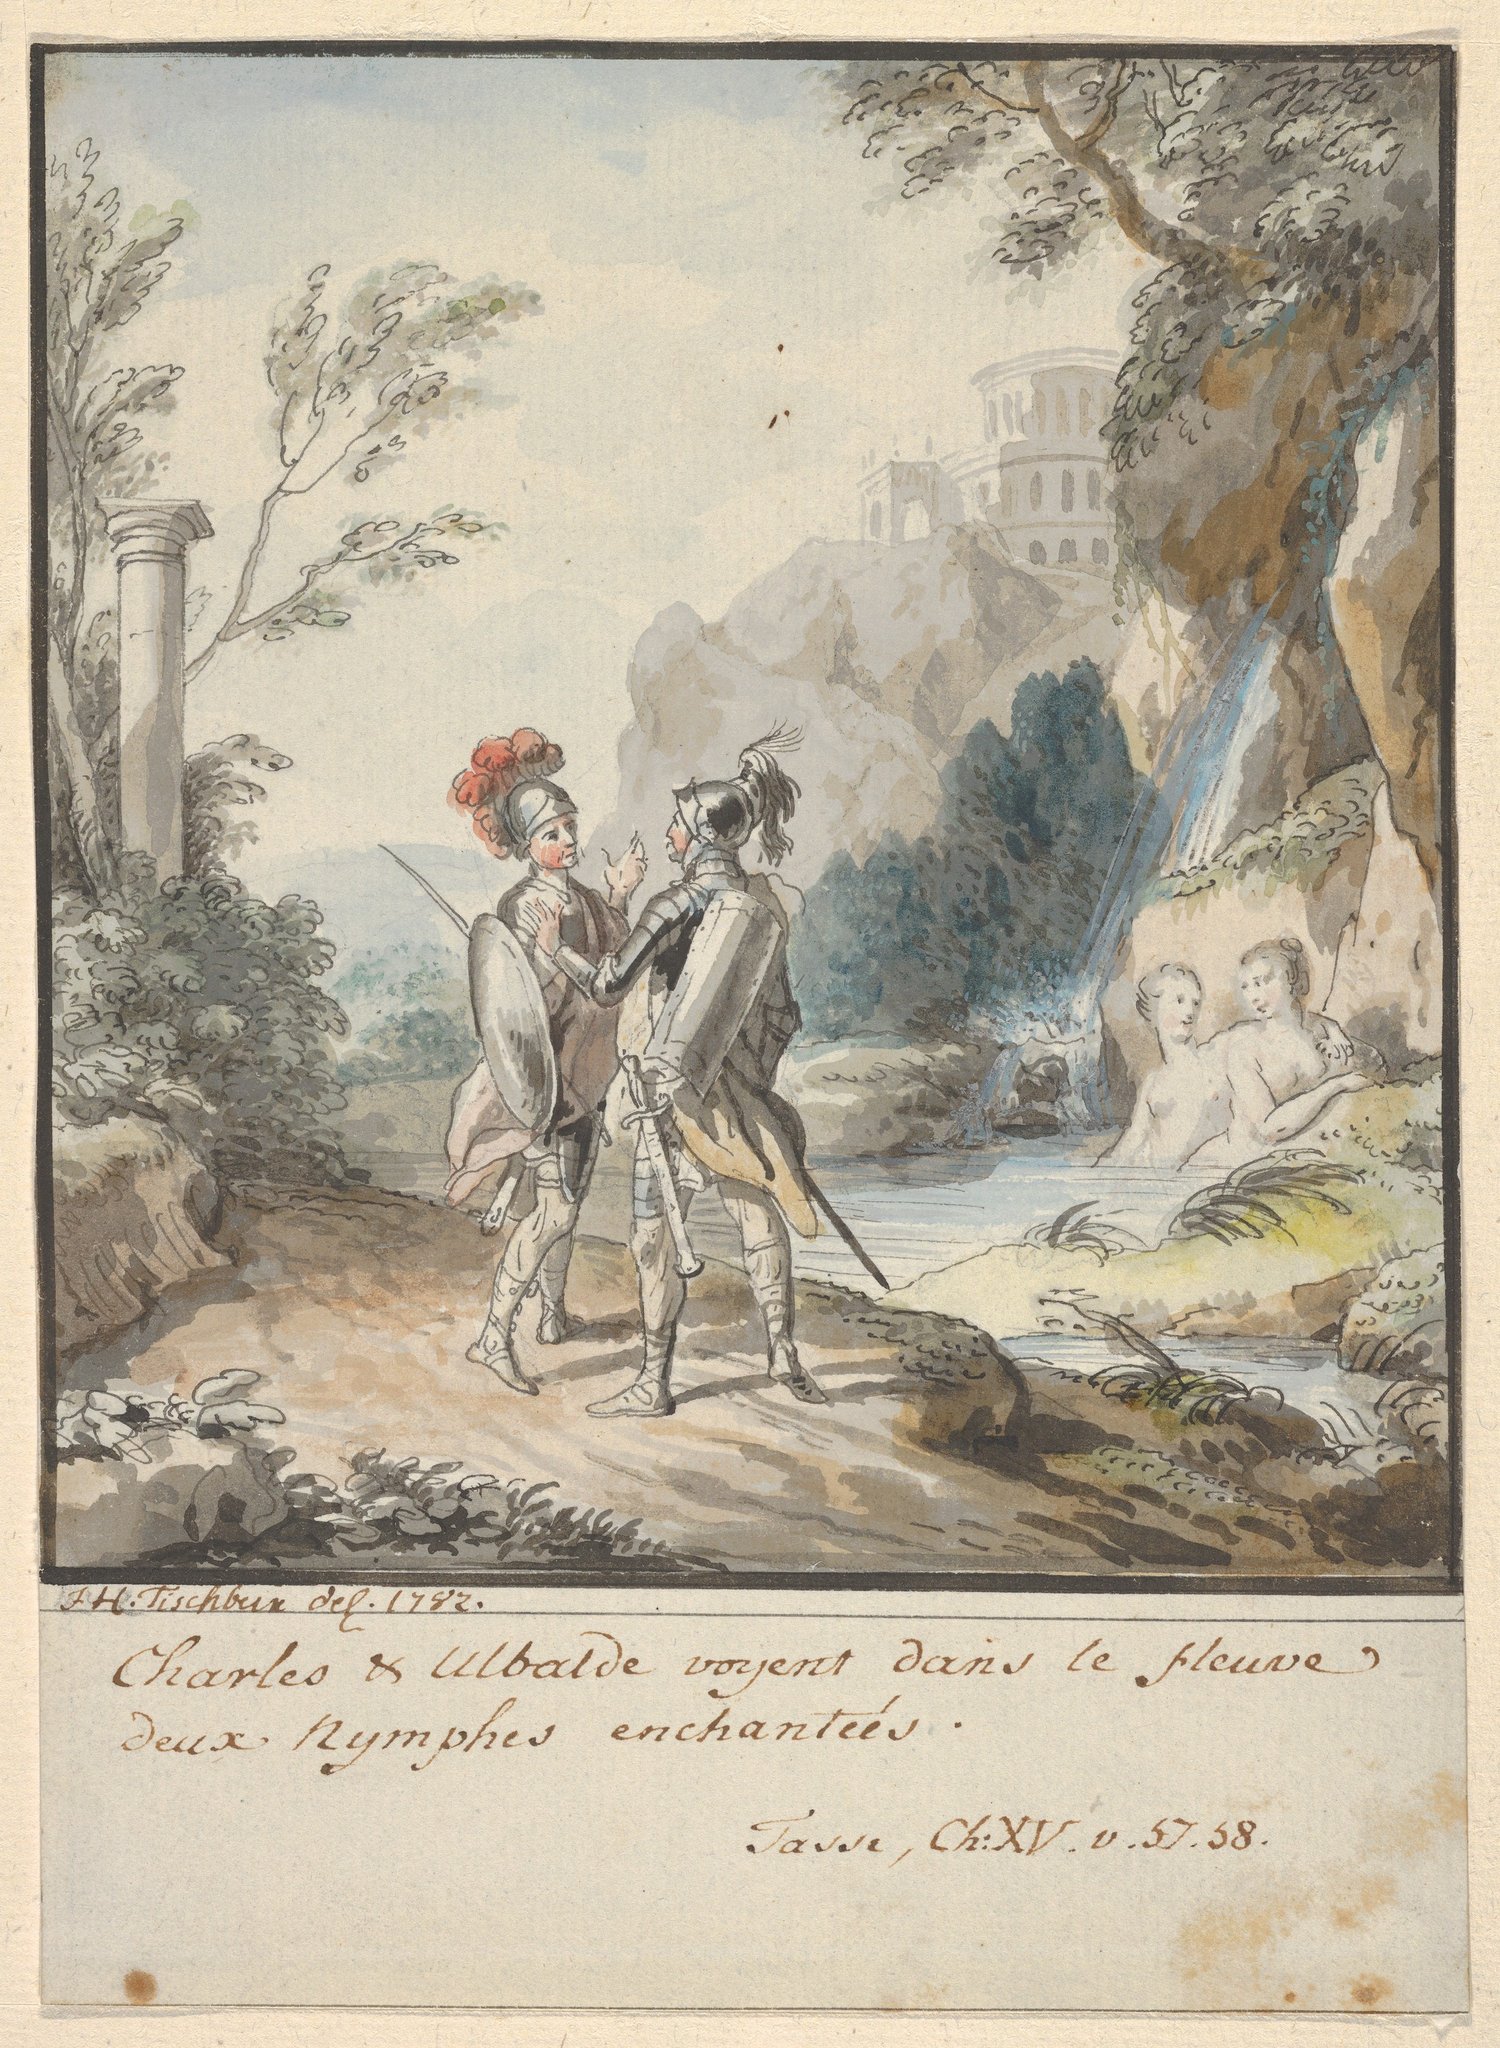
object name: drawing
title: Carlo and Ubaldo Resisting the Enchantments of Armida's Nymphs (from Torquato Tasso's "Gerusalemme liberata", 15:57-58)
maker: johann heinrich tischbein the elder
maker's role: artist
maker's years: 1722-1789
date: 1782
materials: gouache, graphite, ink, watercolor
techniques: pen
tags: buildings,soldiers,men,nymphs,bathing